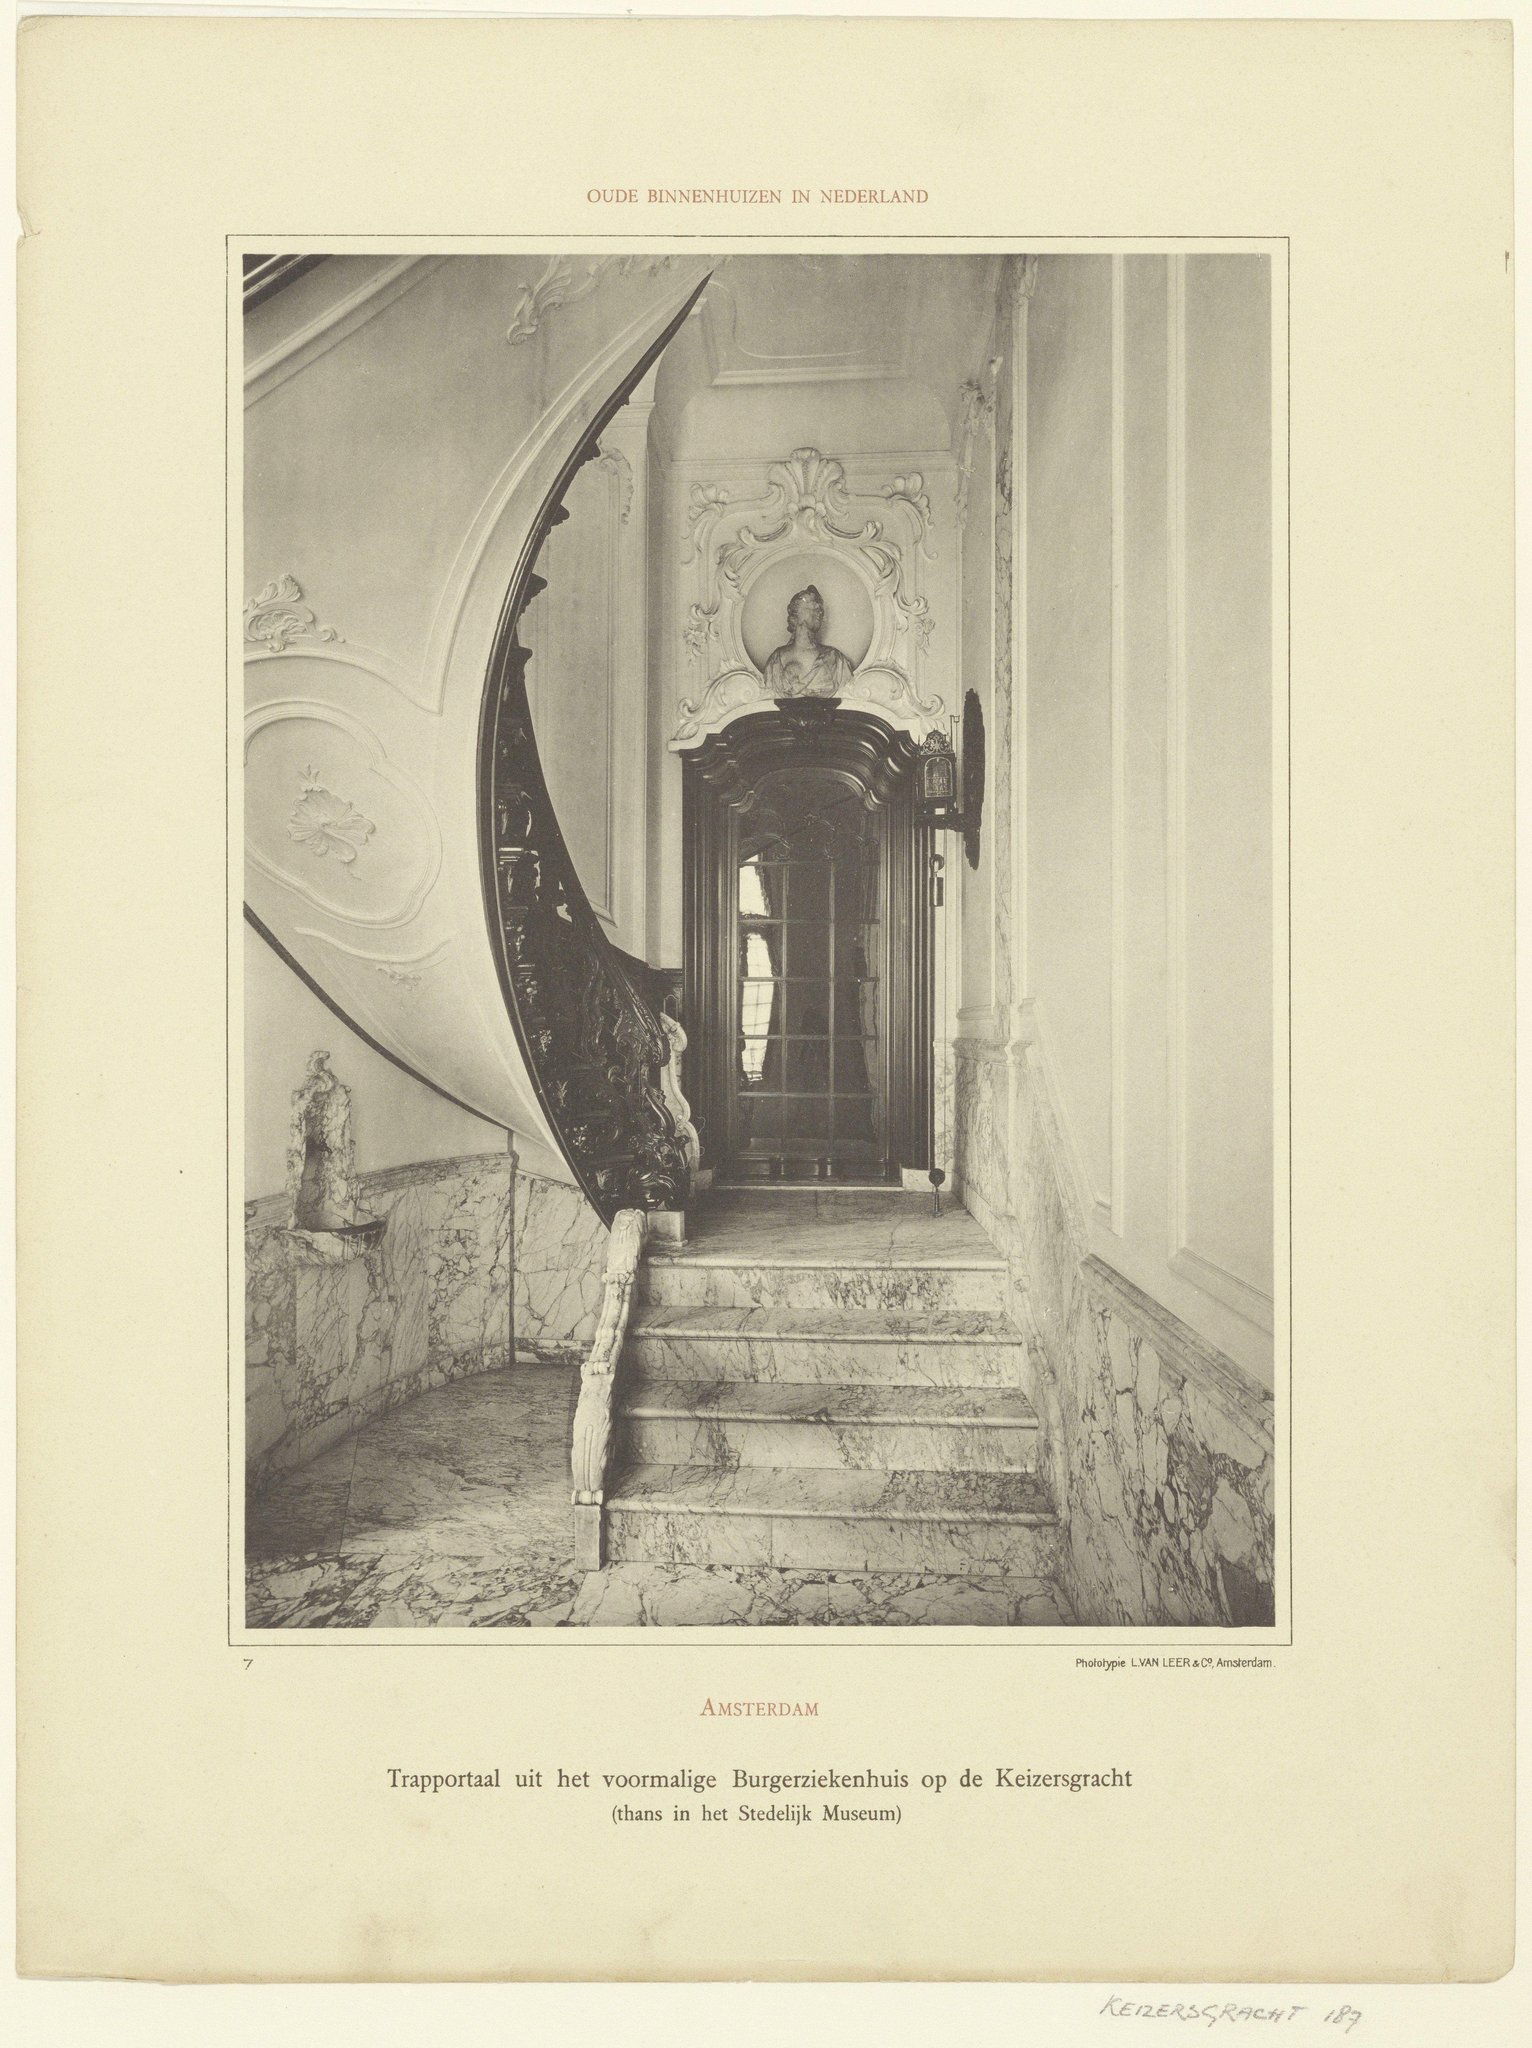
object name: spiral stair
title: Onderdelen van het trapportaal uit het pand aan de Keizersgracht 187 te Amsterdam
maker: Anonymous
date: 1740-1760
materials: wood, marble